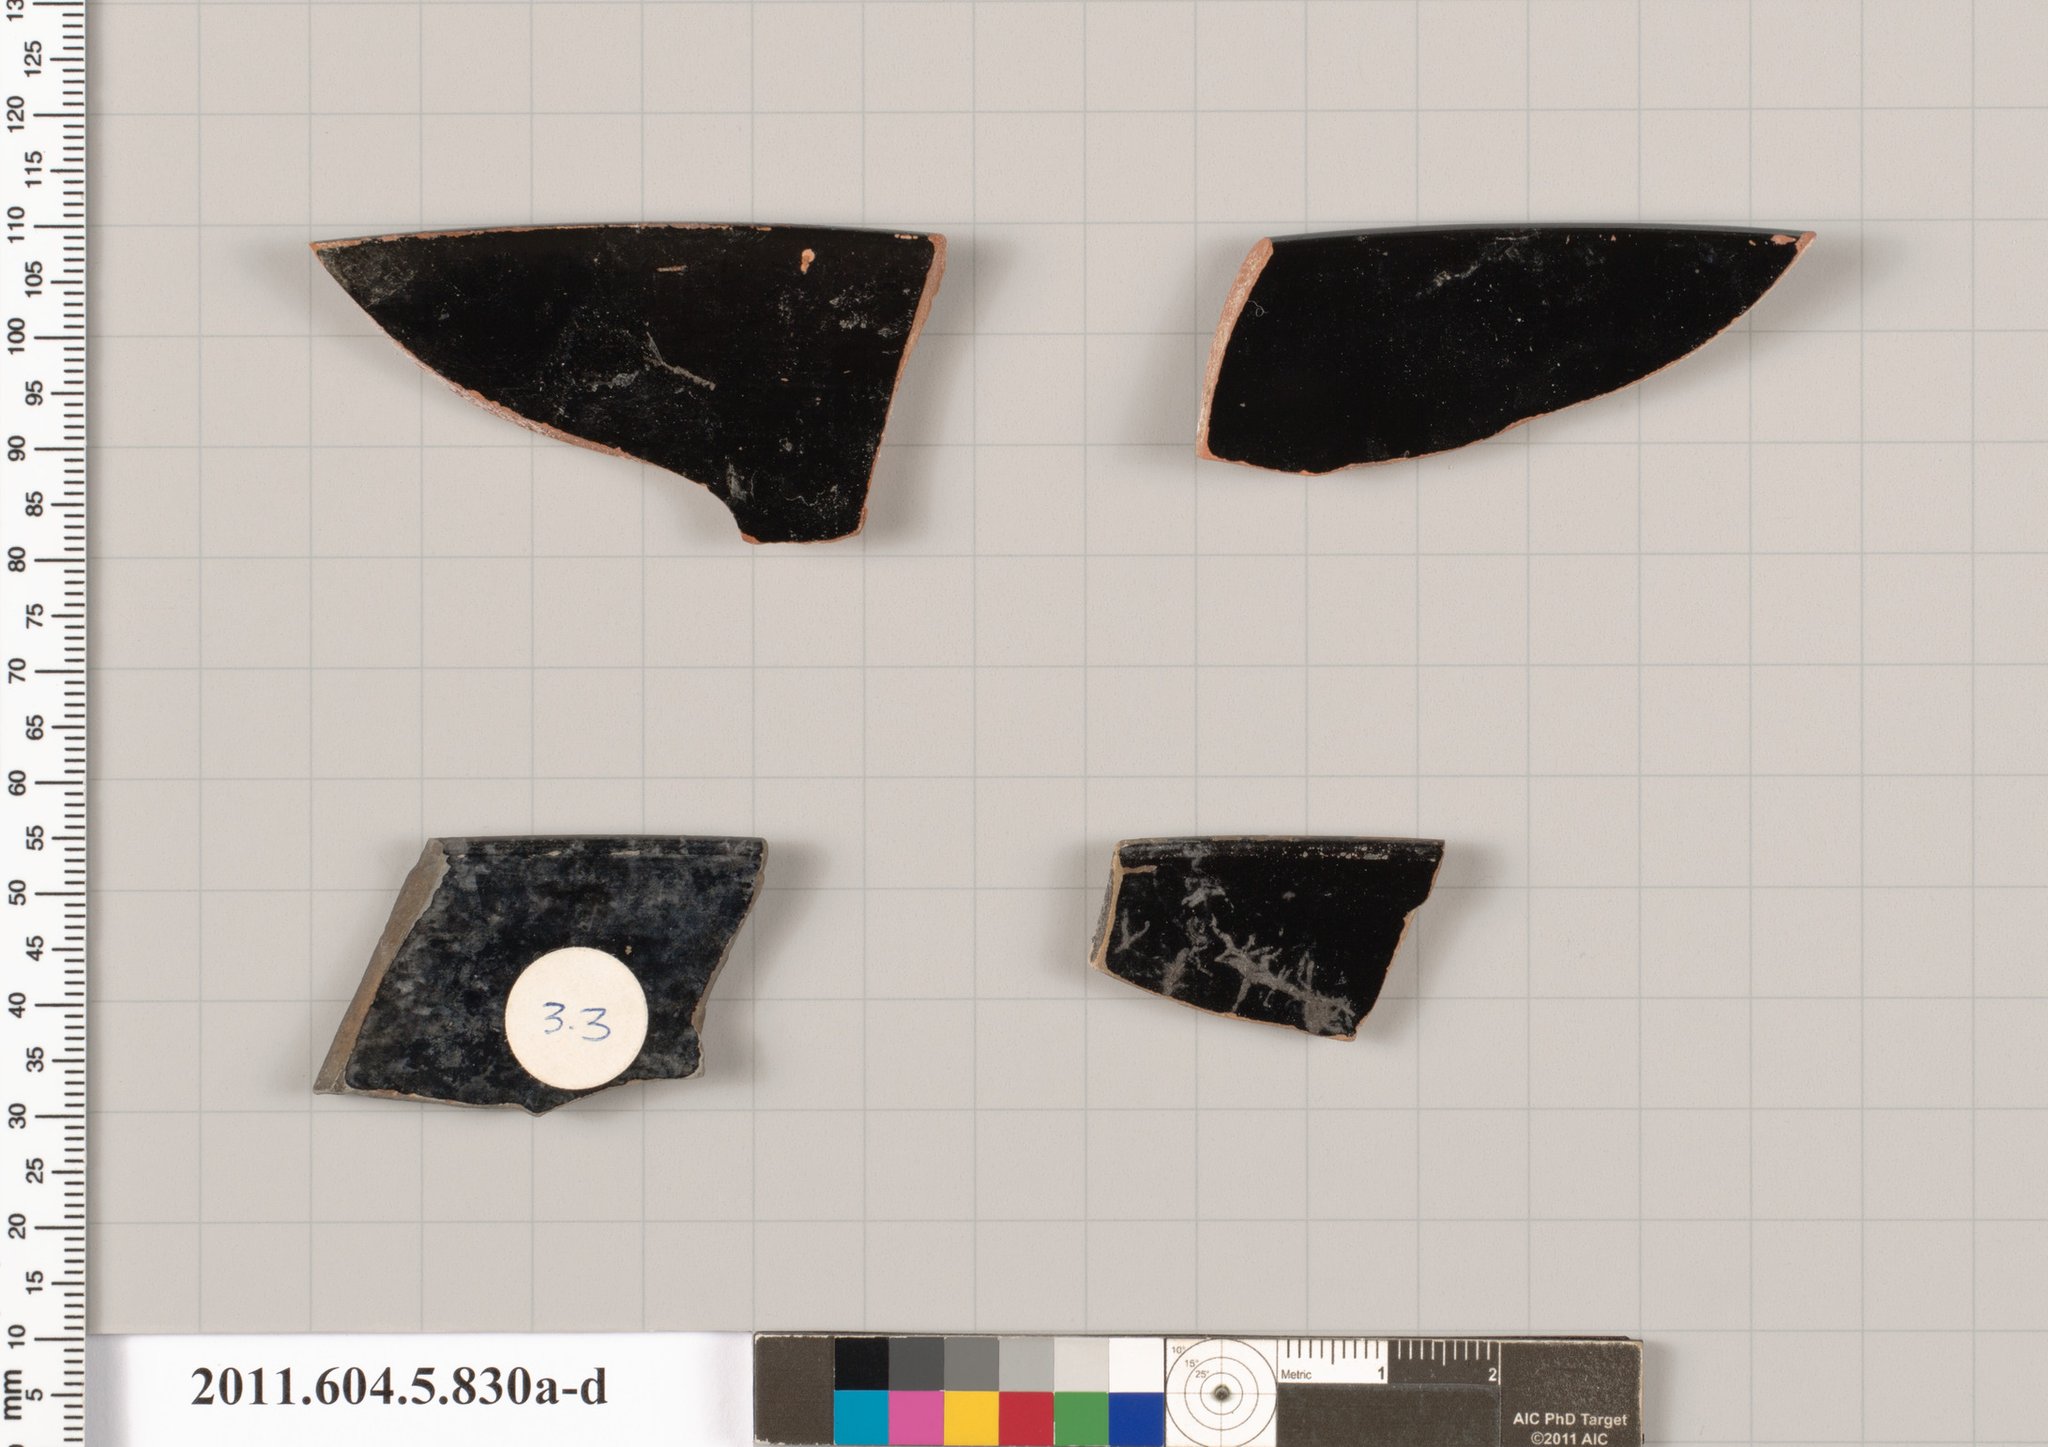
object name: kylix fragment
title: Terracotta rim fragments of kylikes (drinking cups)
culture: greek, attic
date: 600-401 BCE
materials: terracotta